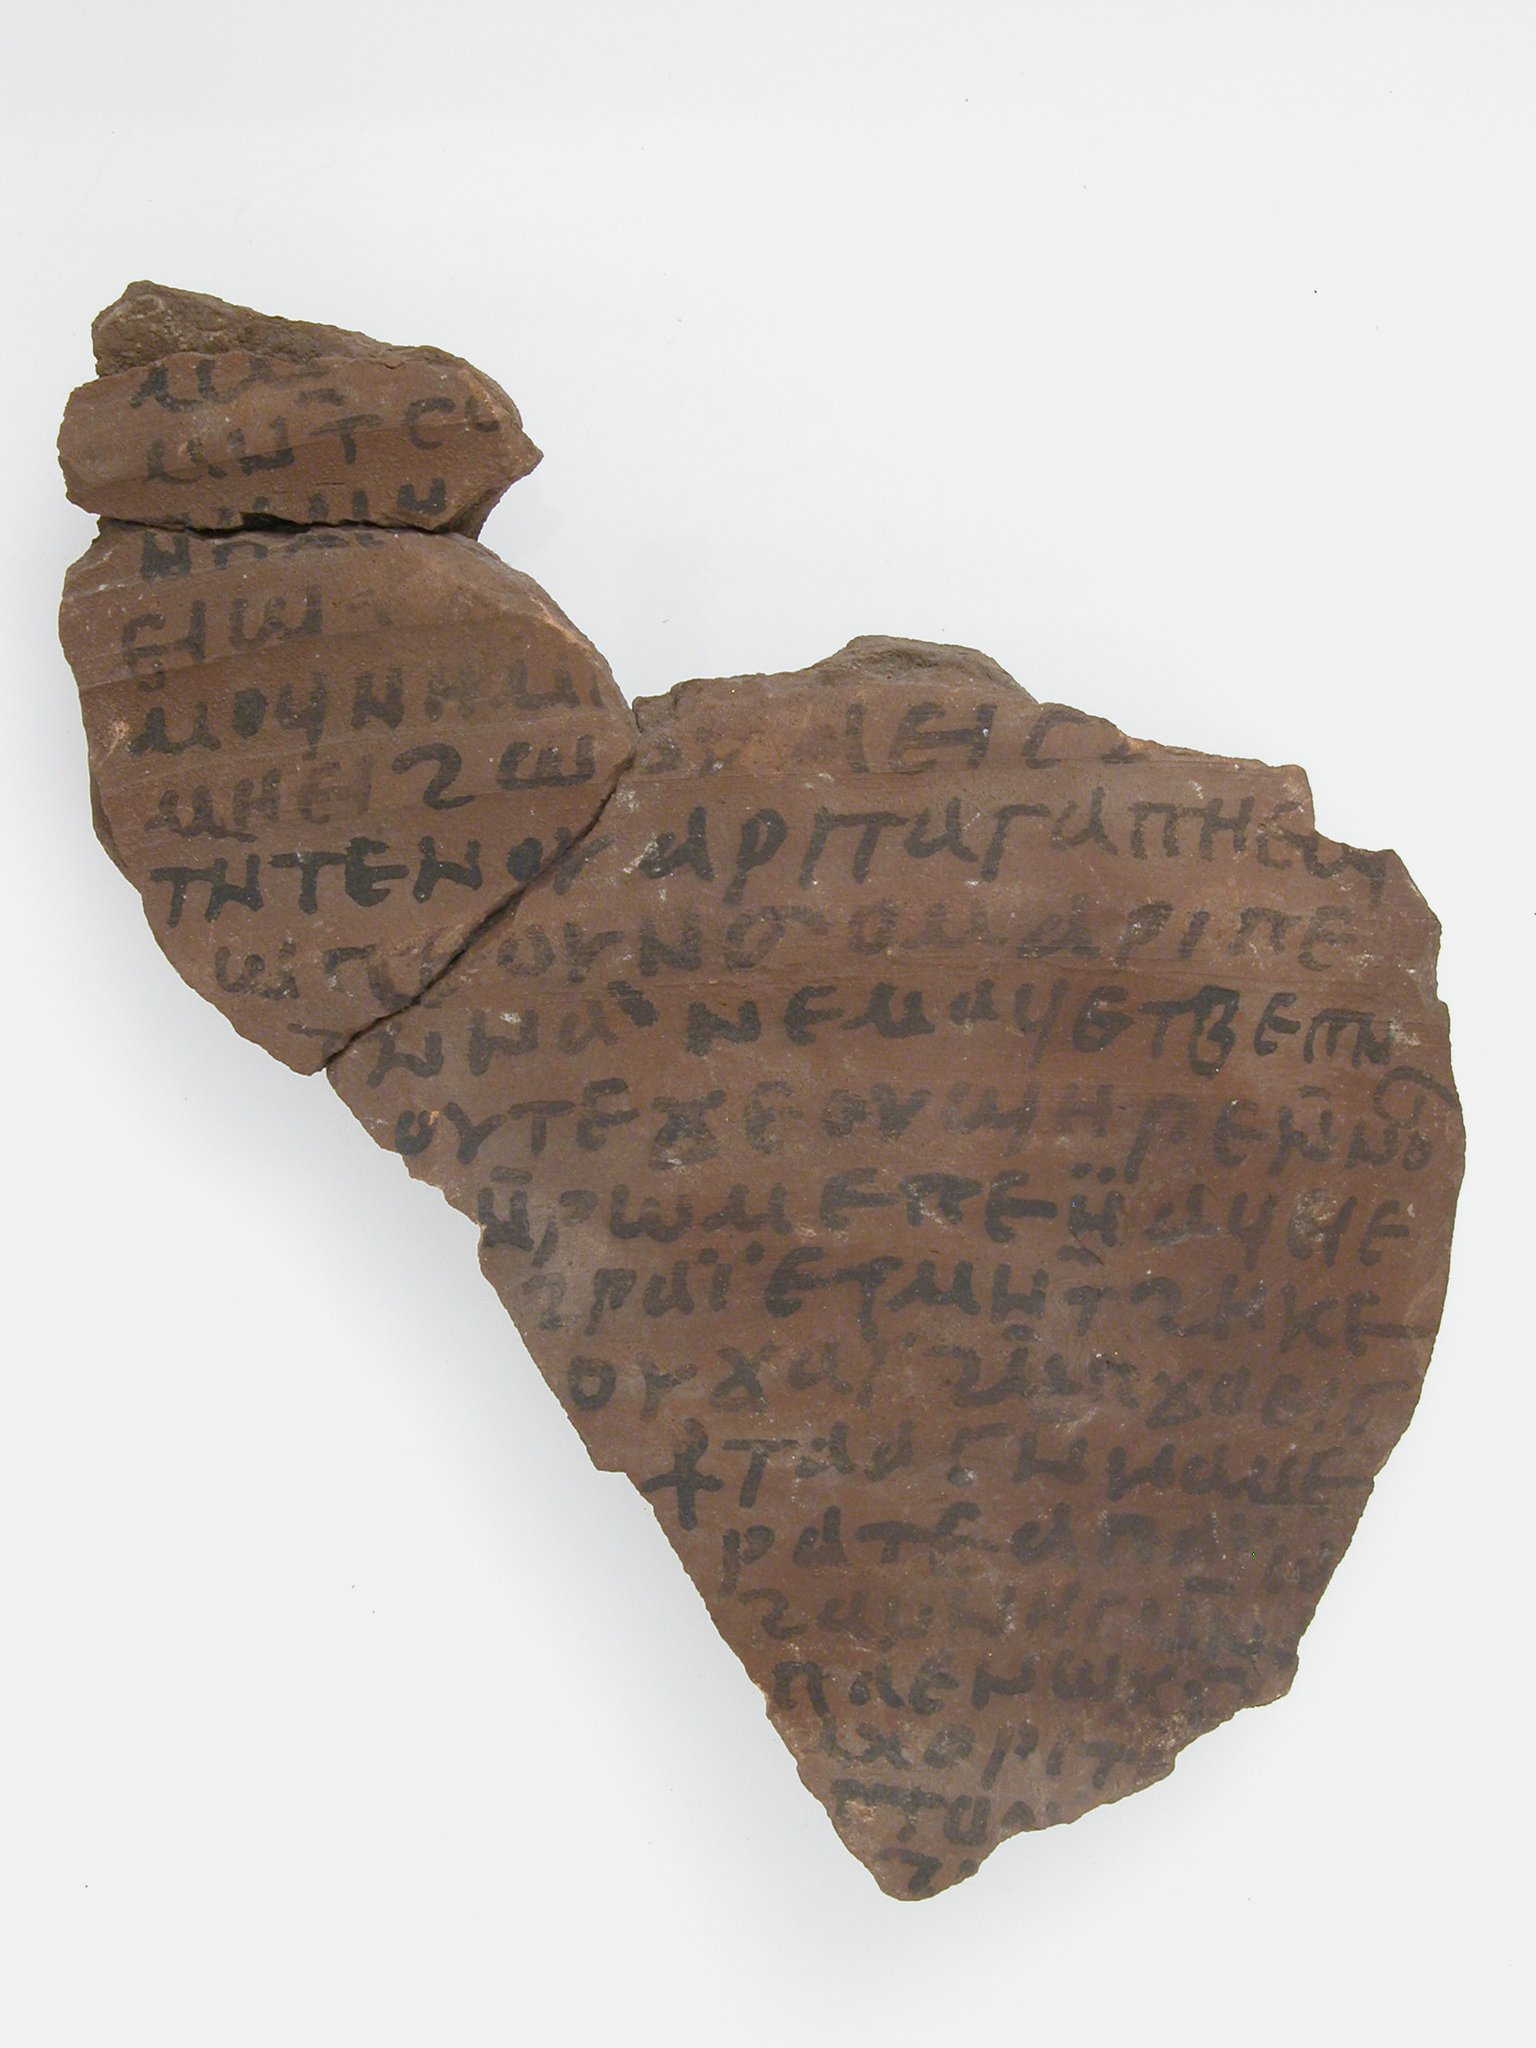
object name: ostrakon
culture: coptic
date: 601-700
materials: ink, pottery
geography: egypt